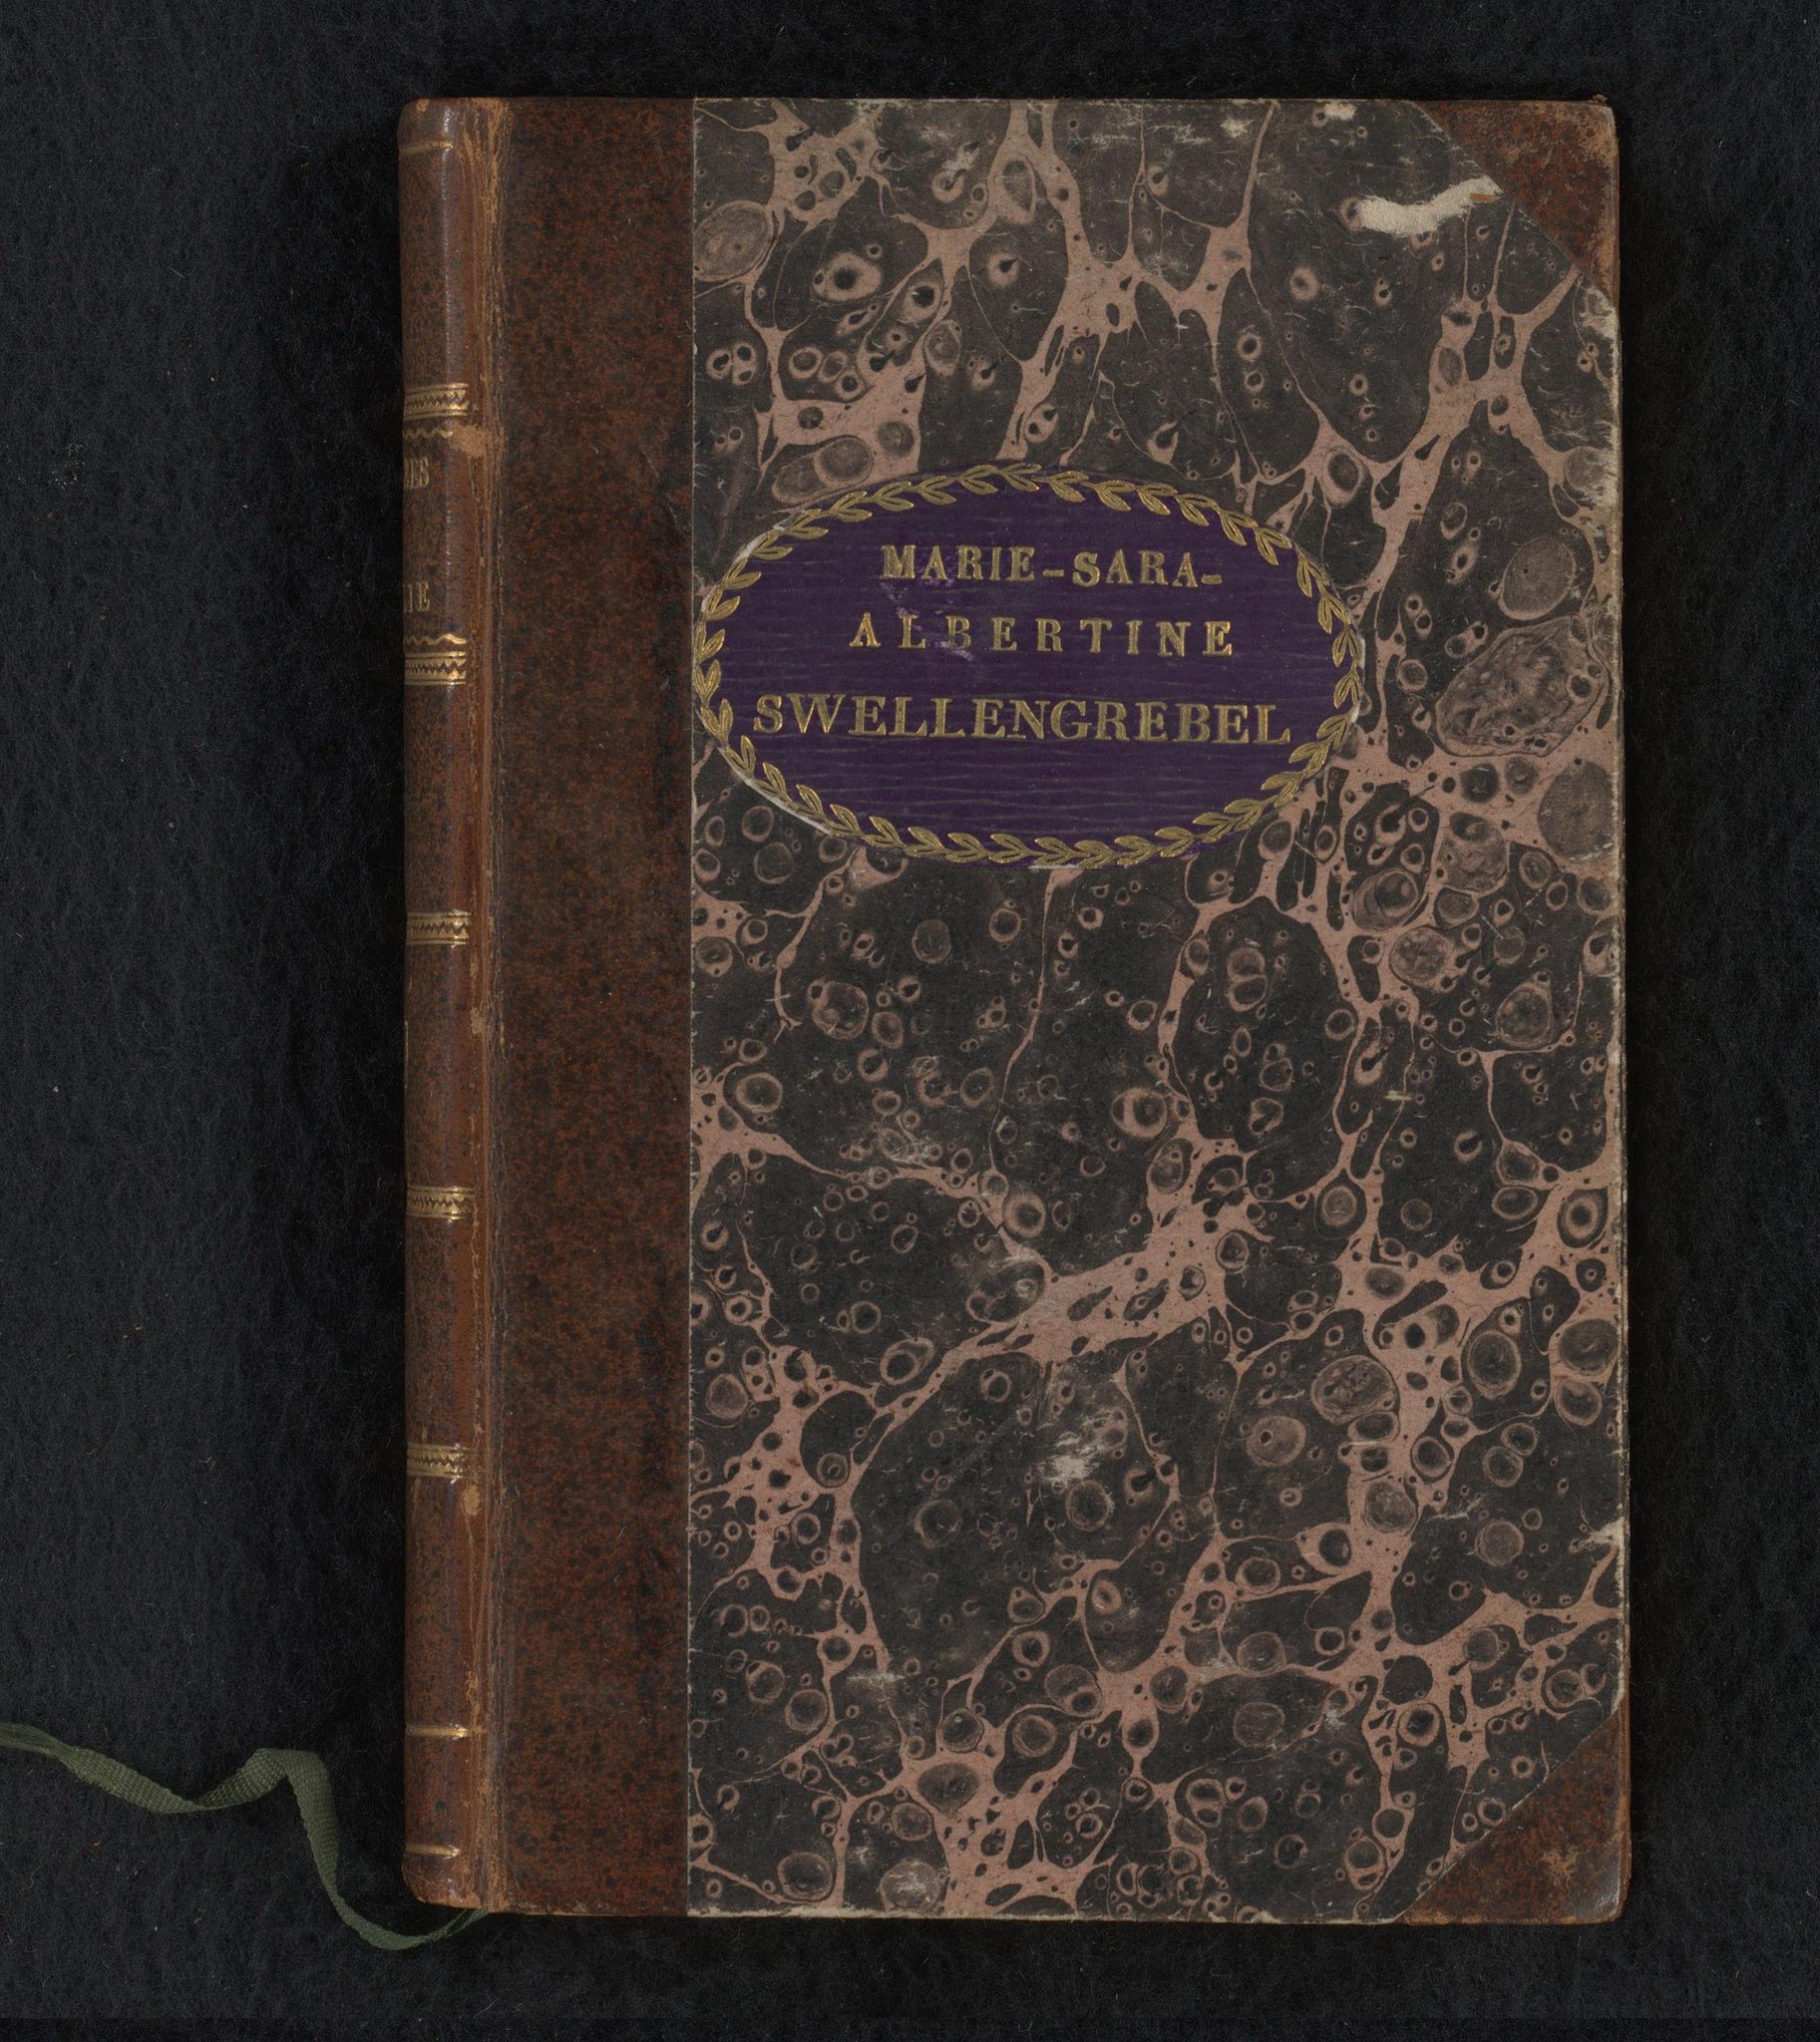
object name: book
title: Lettres a Émilie sur la Mythologie. Par C.A. Demoustier. Première partie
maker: antoine augustin renouard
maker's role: publisher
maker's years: 1765-1853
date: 1817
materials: leather, paper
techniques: letterpress printing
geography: paris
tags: utrecht, maria sara albertina swellengrebel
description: Lettres a Émilie sur la Mythologie, dl. 1. Boek uit het bezit van Marie Sara Albertine Swellengrebel. Gebonden met de titel en deelnummer 1 op de rug en de naam van de eigenares in een ovaal vignet op de voorkant.